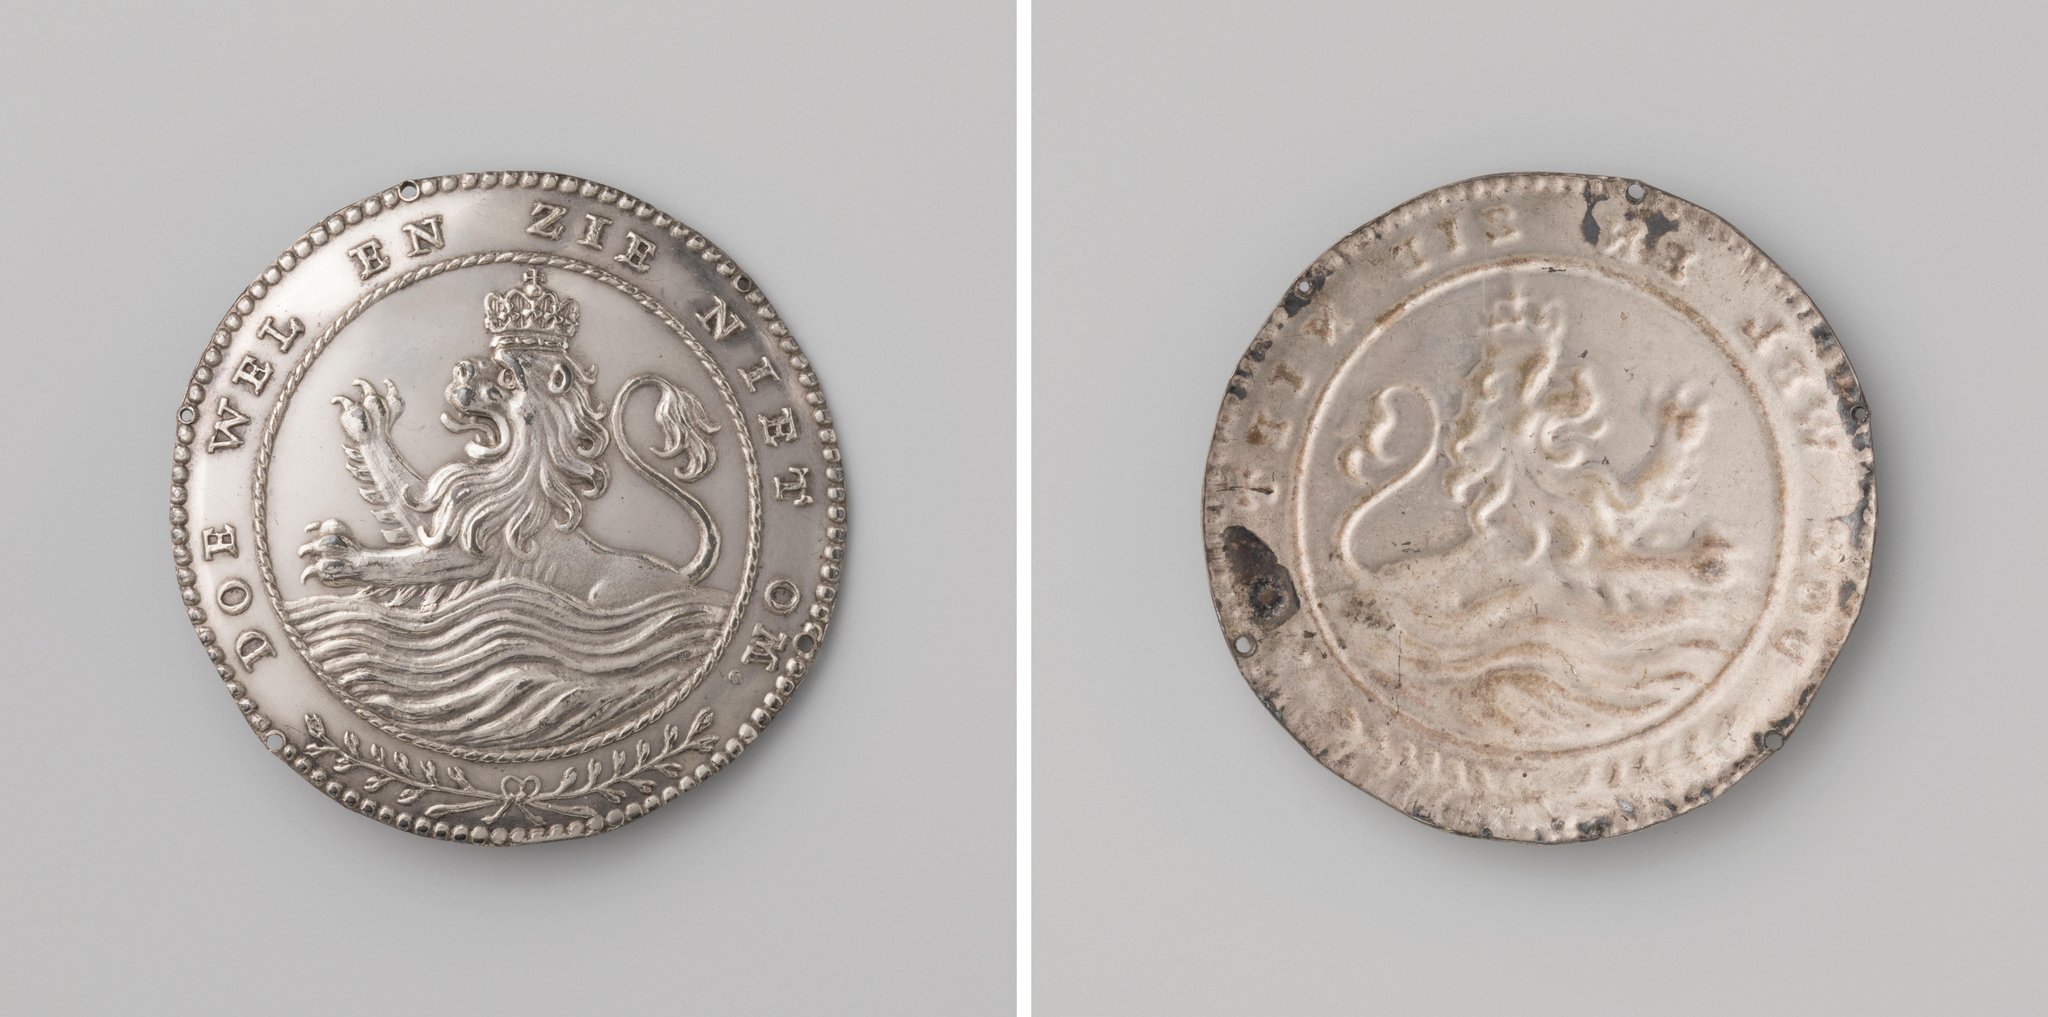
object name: ordeteken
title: Grootkruis van de Orde van de Unie, behoord hebbend aan I.J.A. Gogel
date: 1811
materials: silver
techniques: striking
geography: netherlands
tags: vught, overveen, minister, staatsman, intendant-generaal van financien, secretaris van staat voor financien, minister van financiën, izaak jean alexandre gogel, orde van de unie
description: Decorations and medals, 1806-1813. King Louis Napoleon instituted two national orders: the Order of Merit, with the motto 'do well and do not look back', and the Order of the Union, with the motto 'luctor et emergo'. A year later the two orders were merged to form the Royal Order of Holland, renamed the Royal Order of the Union after 1808. Instead of the king's head, the medal showed a bundle of arrows. When the Netherlands was annexed by France in 1810, Emperor Napoleon introduced the Order of Reunion to replace the Order of the Union. These decorations were originally awarded to I.J.A. Gogel, who served for many years as minister of finance.